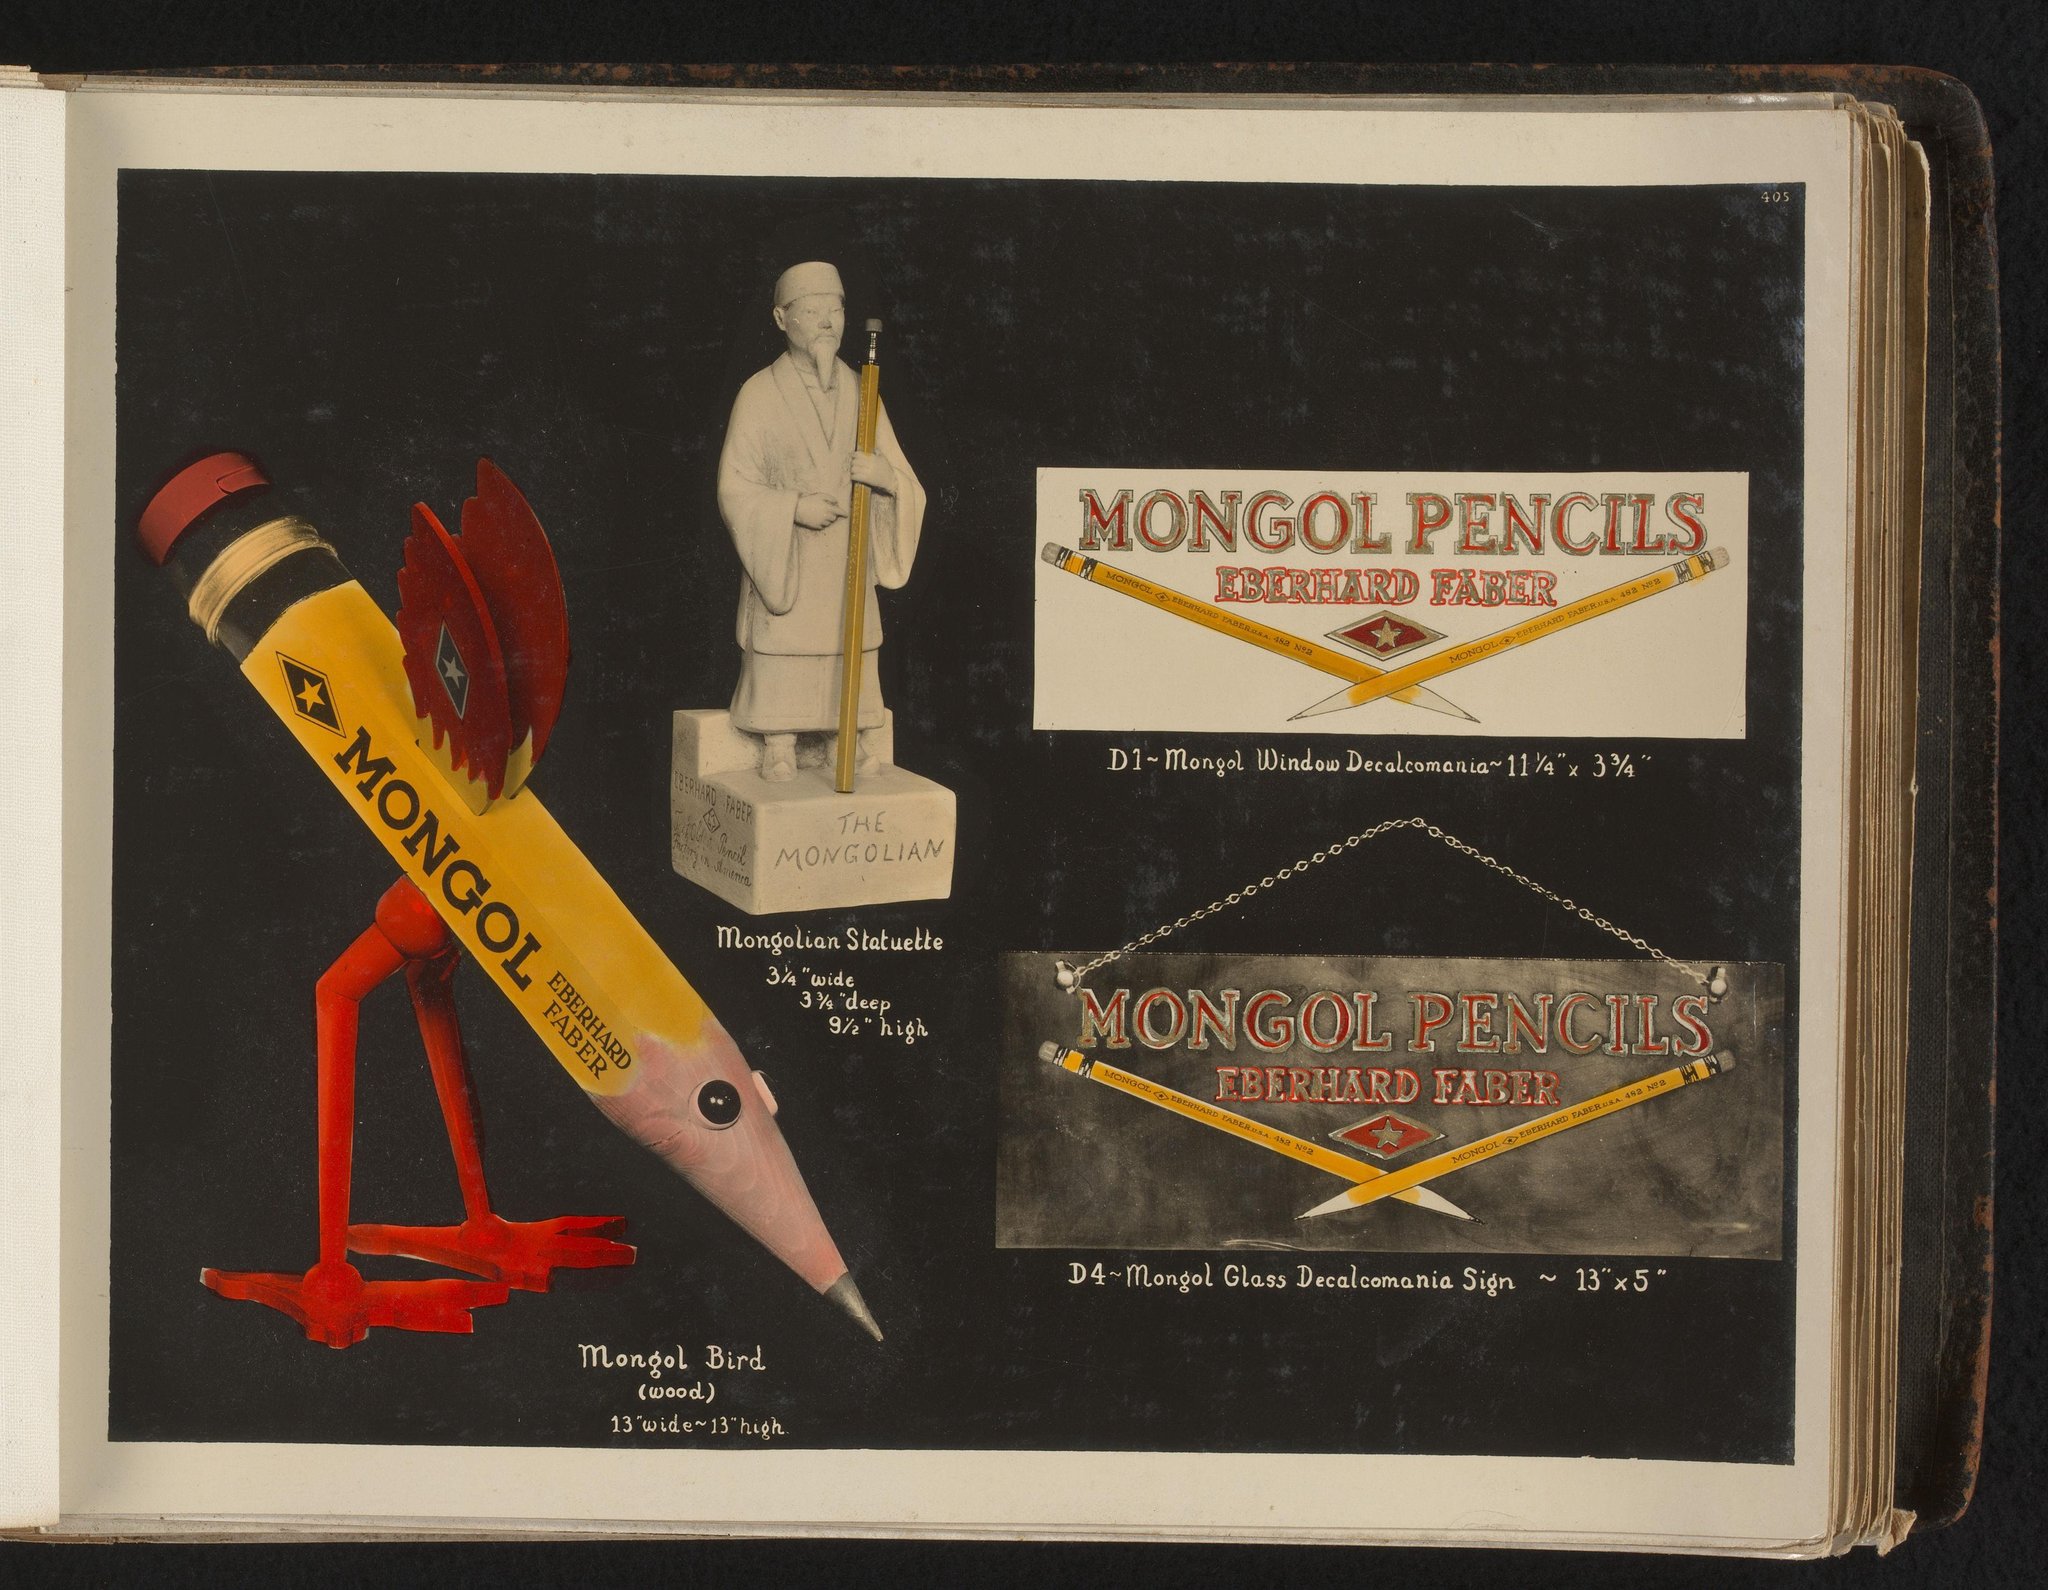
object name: album leaf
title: Reclamemateriaal voor potloden van Eberhard Faber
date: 1915-1935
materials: paper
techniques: gelatin silver print, hand coloring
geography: springfield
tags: pencil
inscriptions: number: ‘405’, stamp: ‘Paramount/ Commercial Studios/ 145 Chestnut St./ Springfield - Mass.’